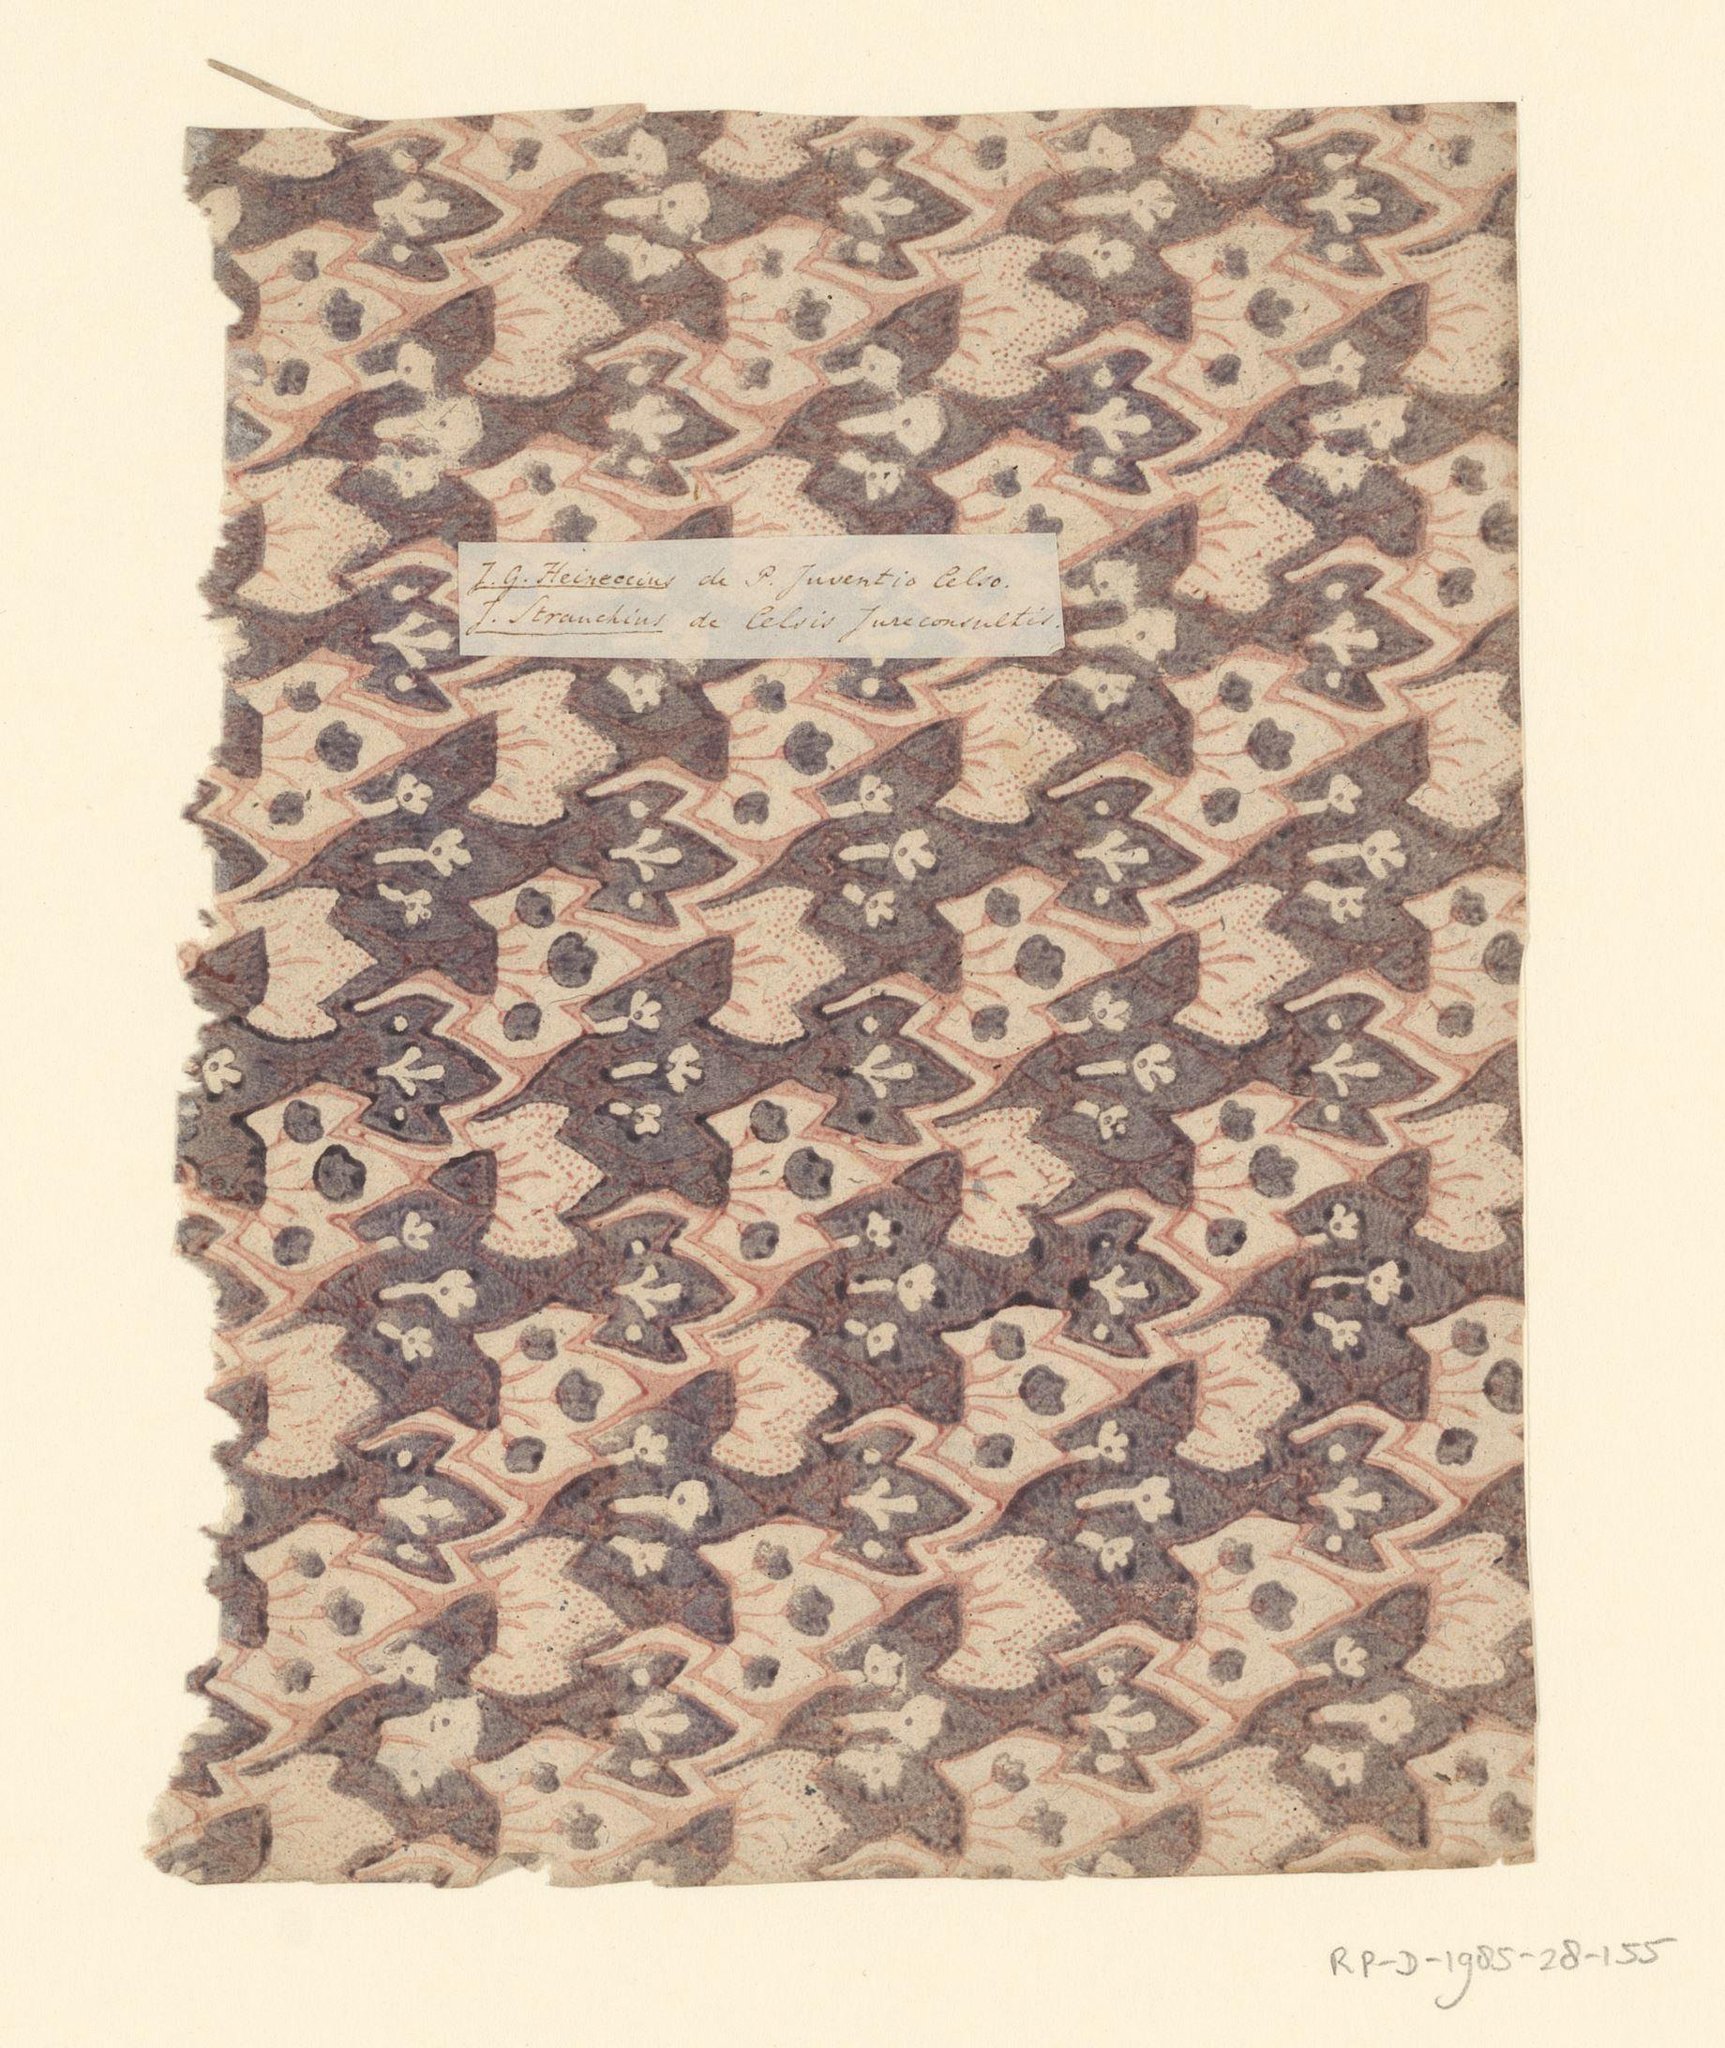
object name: printed paper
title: Blad met alternerend strooipatroon van bloemen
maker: Anonymous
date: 1750-1900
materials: paper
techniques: printing block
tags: ornament derived from plant forms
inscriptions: collector's mark: Lugt 2228, collector's mark: Lugt 2760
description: Blad met alternerend strooipatroon van bloemen. Met etiket met opschrift: 'J.G. Heineocius ... Jure consultis.' Helft van een omslag.